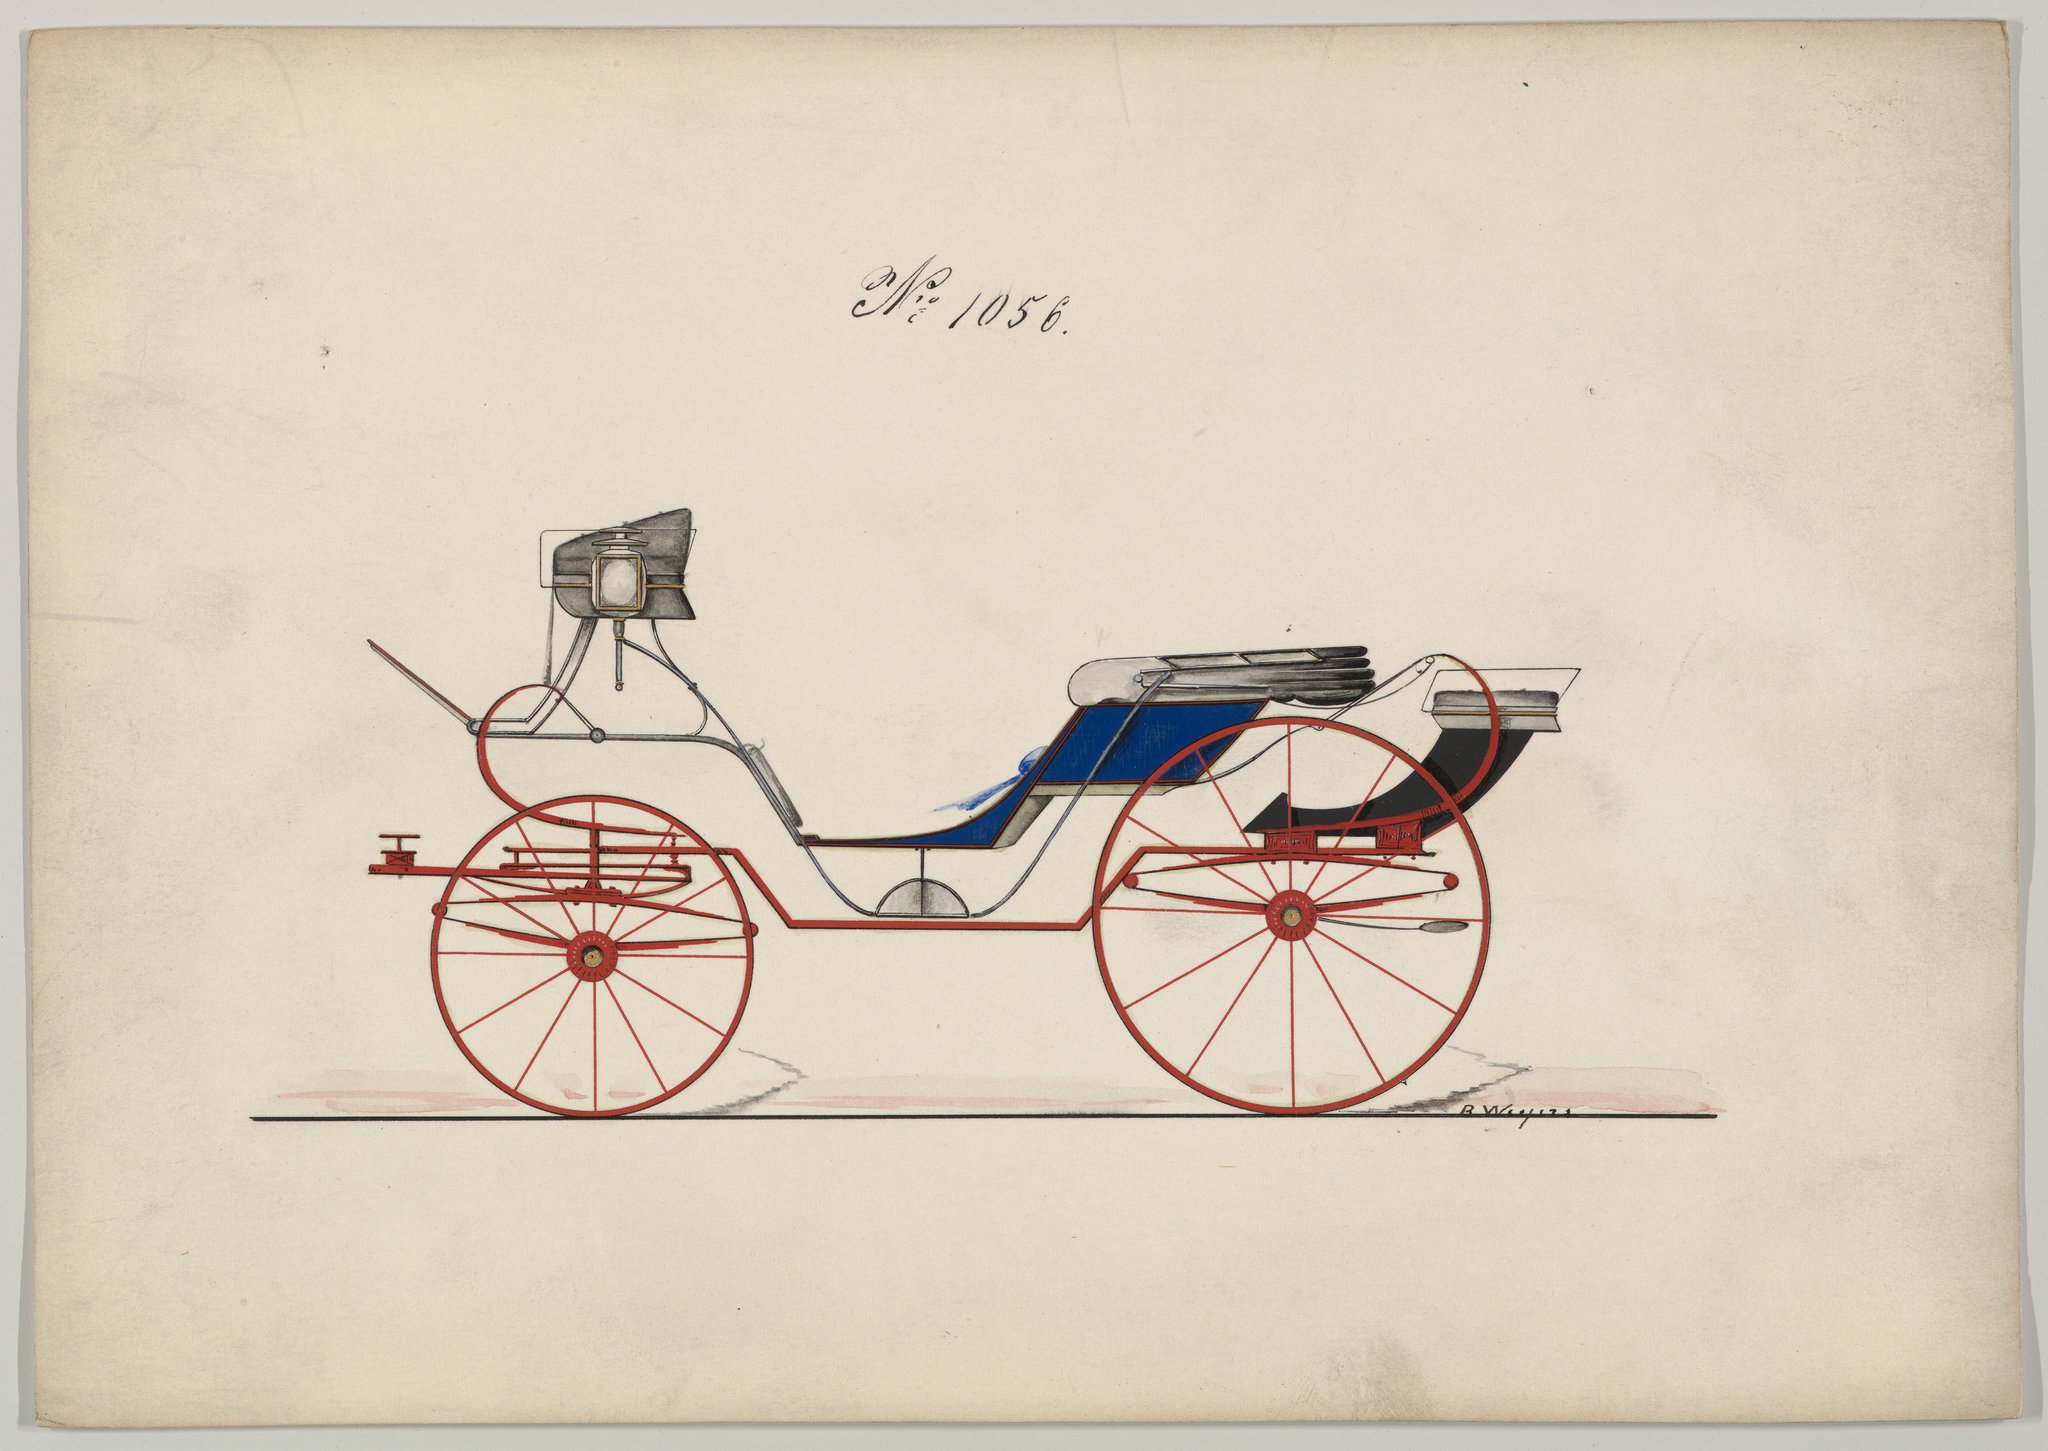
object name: drawing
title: Victoria #1056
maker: brewster & co.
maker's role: manufacturer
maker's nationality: american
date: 1870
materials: gouache, gum arabic, ink, watercolor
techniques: pen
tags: carriages